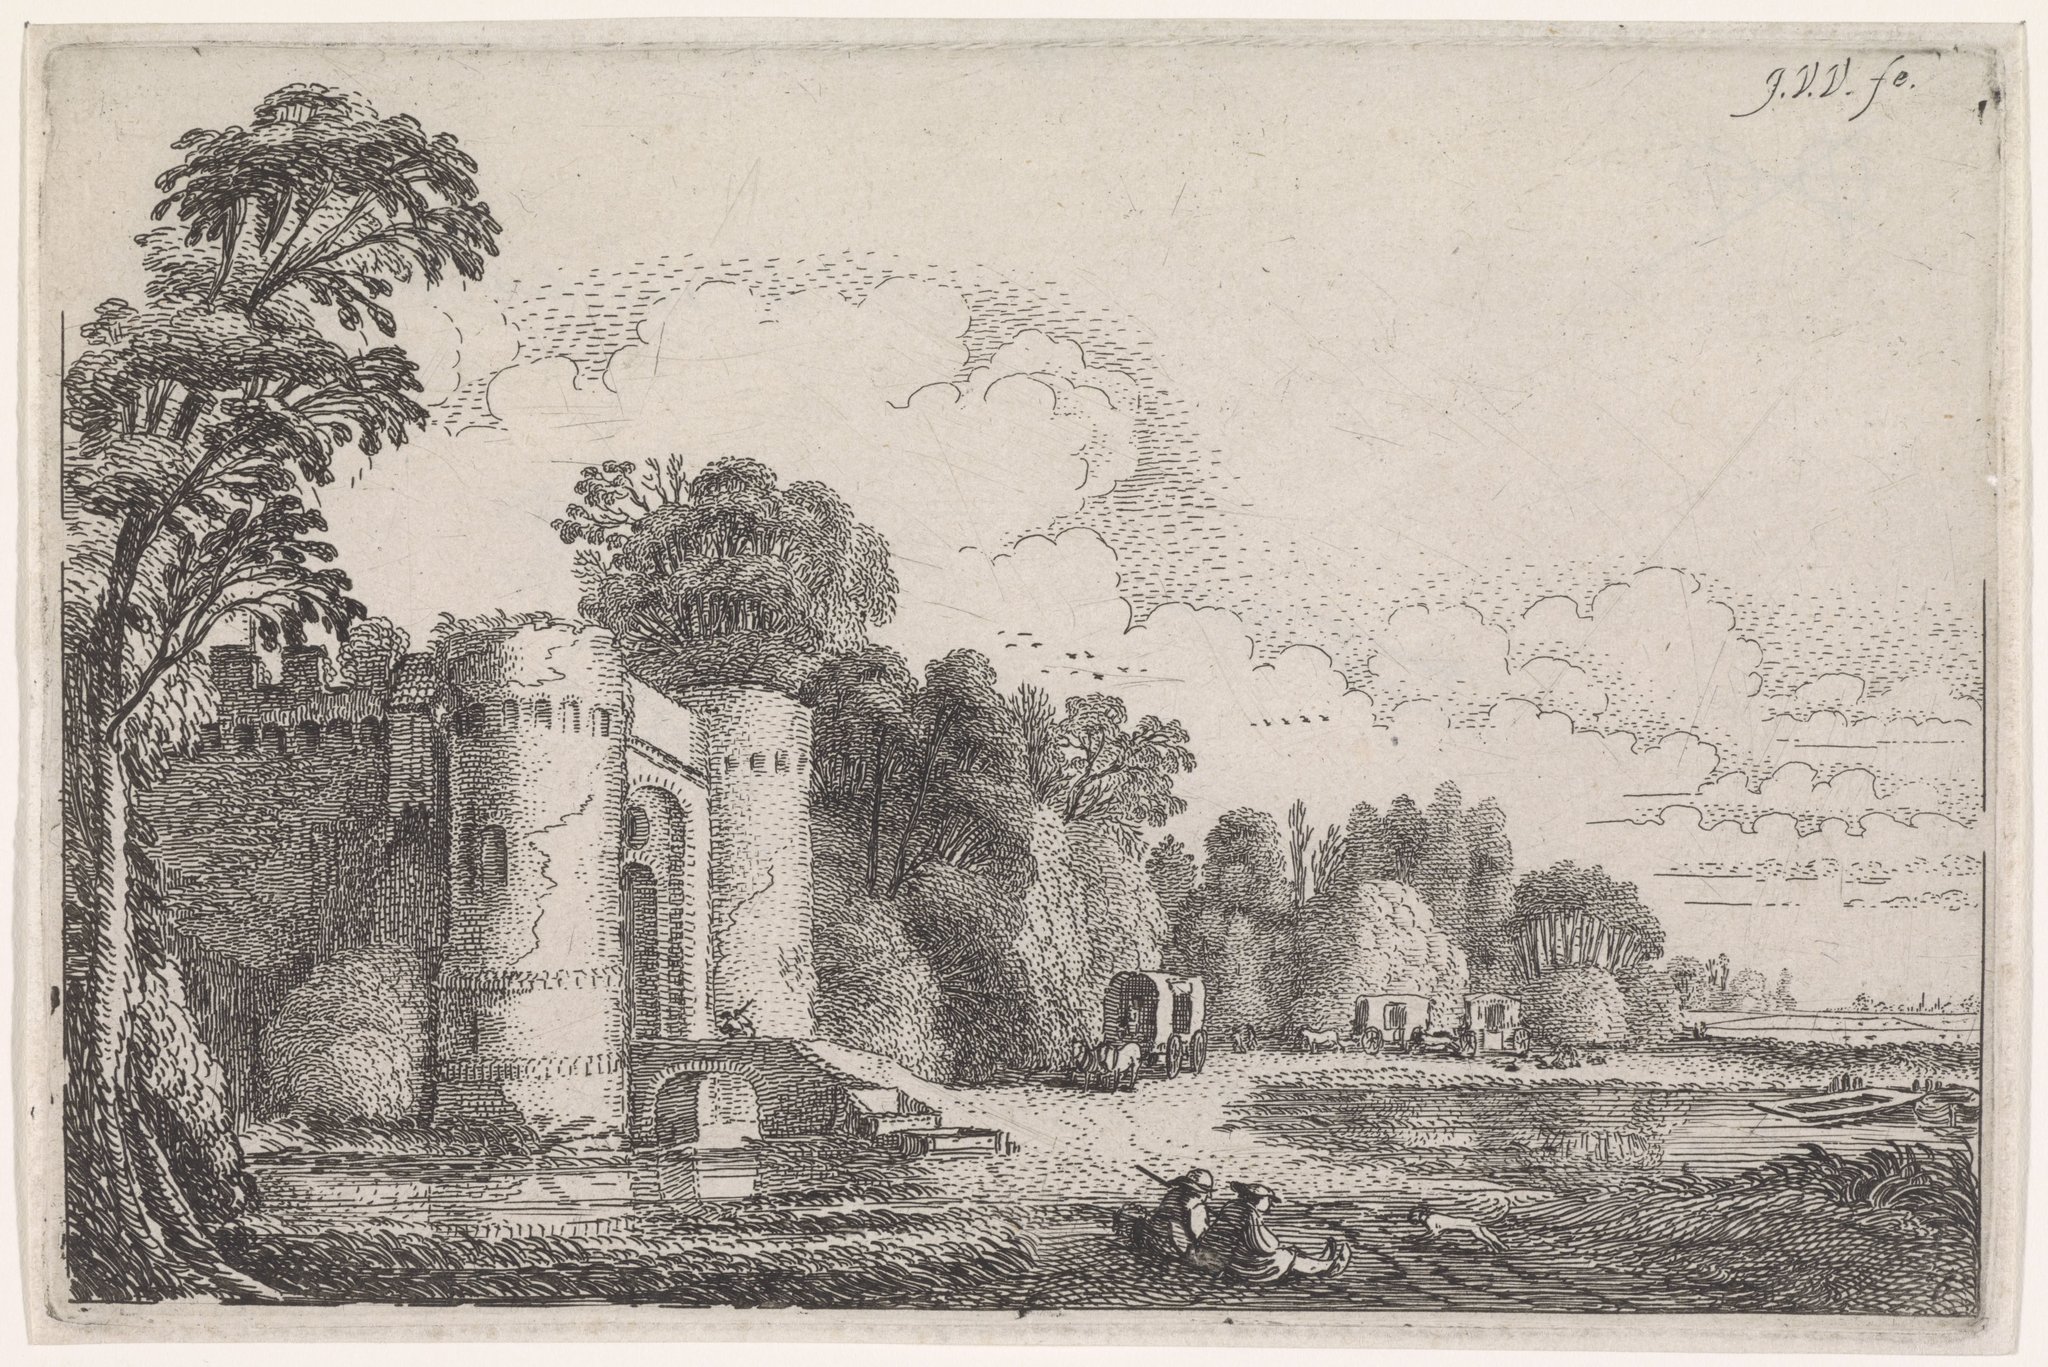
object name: print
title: Rivierlandschappen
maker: jan van de velde (ii)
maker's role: draughtsman, painter, print maker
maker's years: 1593-1641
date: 1603-1641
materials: paper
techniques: etching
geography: northern netherlands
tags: river, landscape with tower or castle, covered wagon, hooded wagon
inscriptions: collector's mark: Lugt 2228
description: Twee zittende figuren op een pad langs een kasteel aan een rivier. Op het pad drie huifkarren. Prent uit een serie met rivierlandschappen.